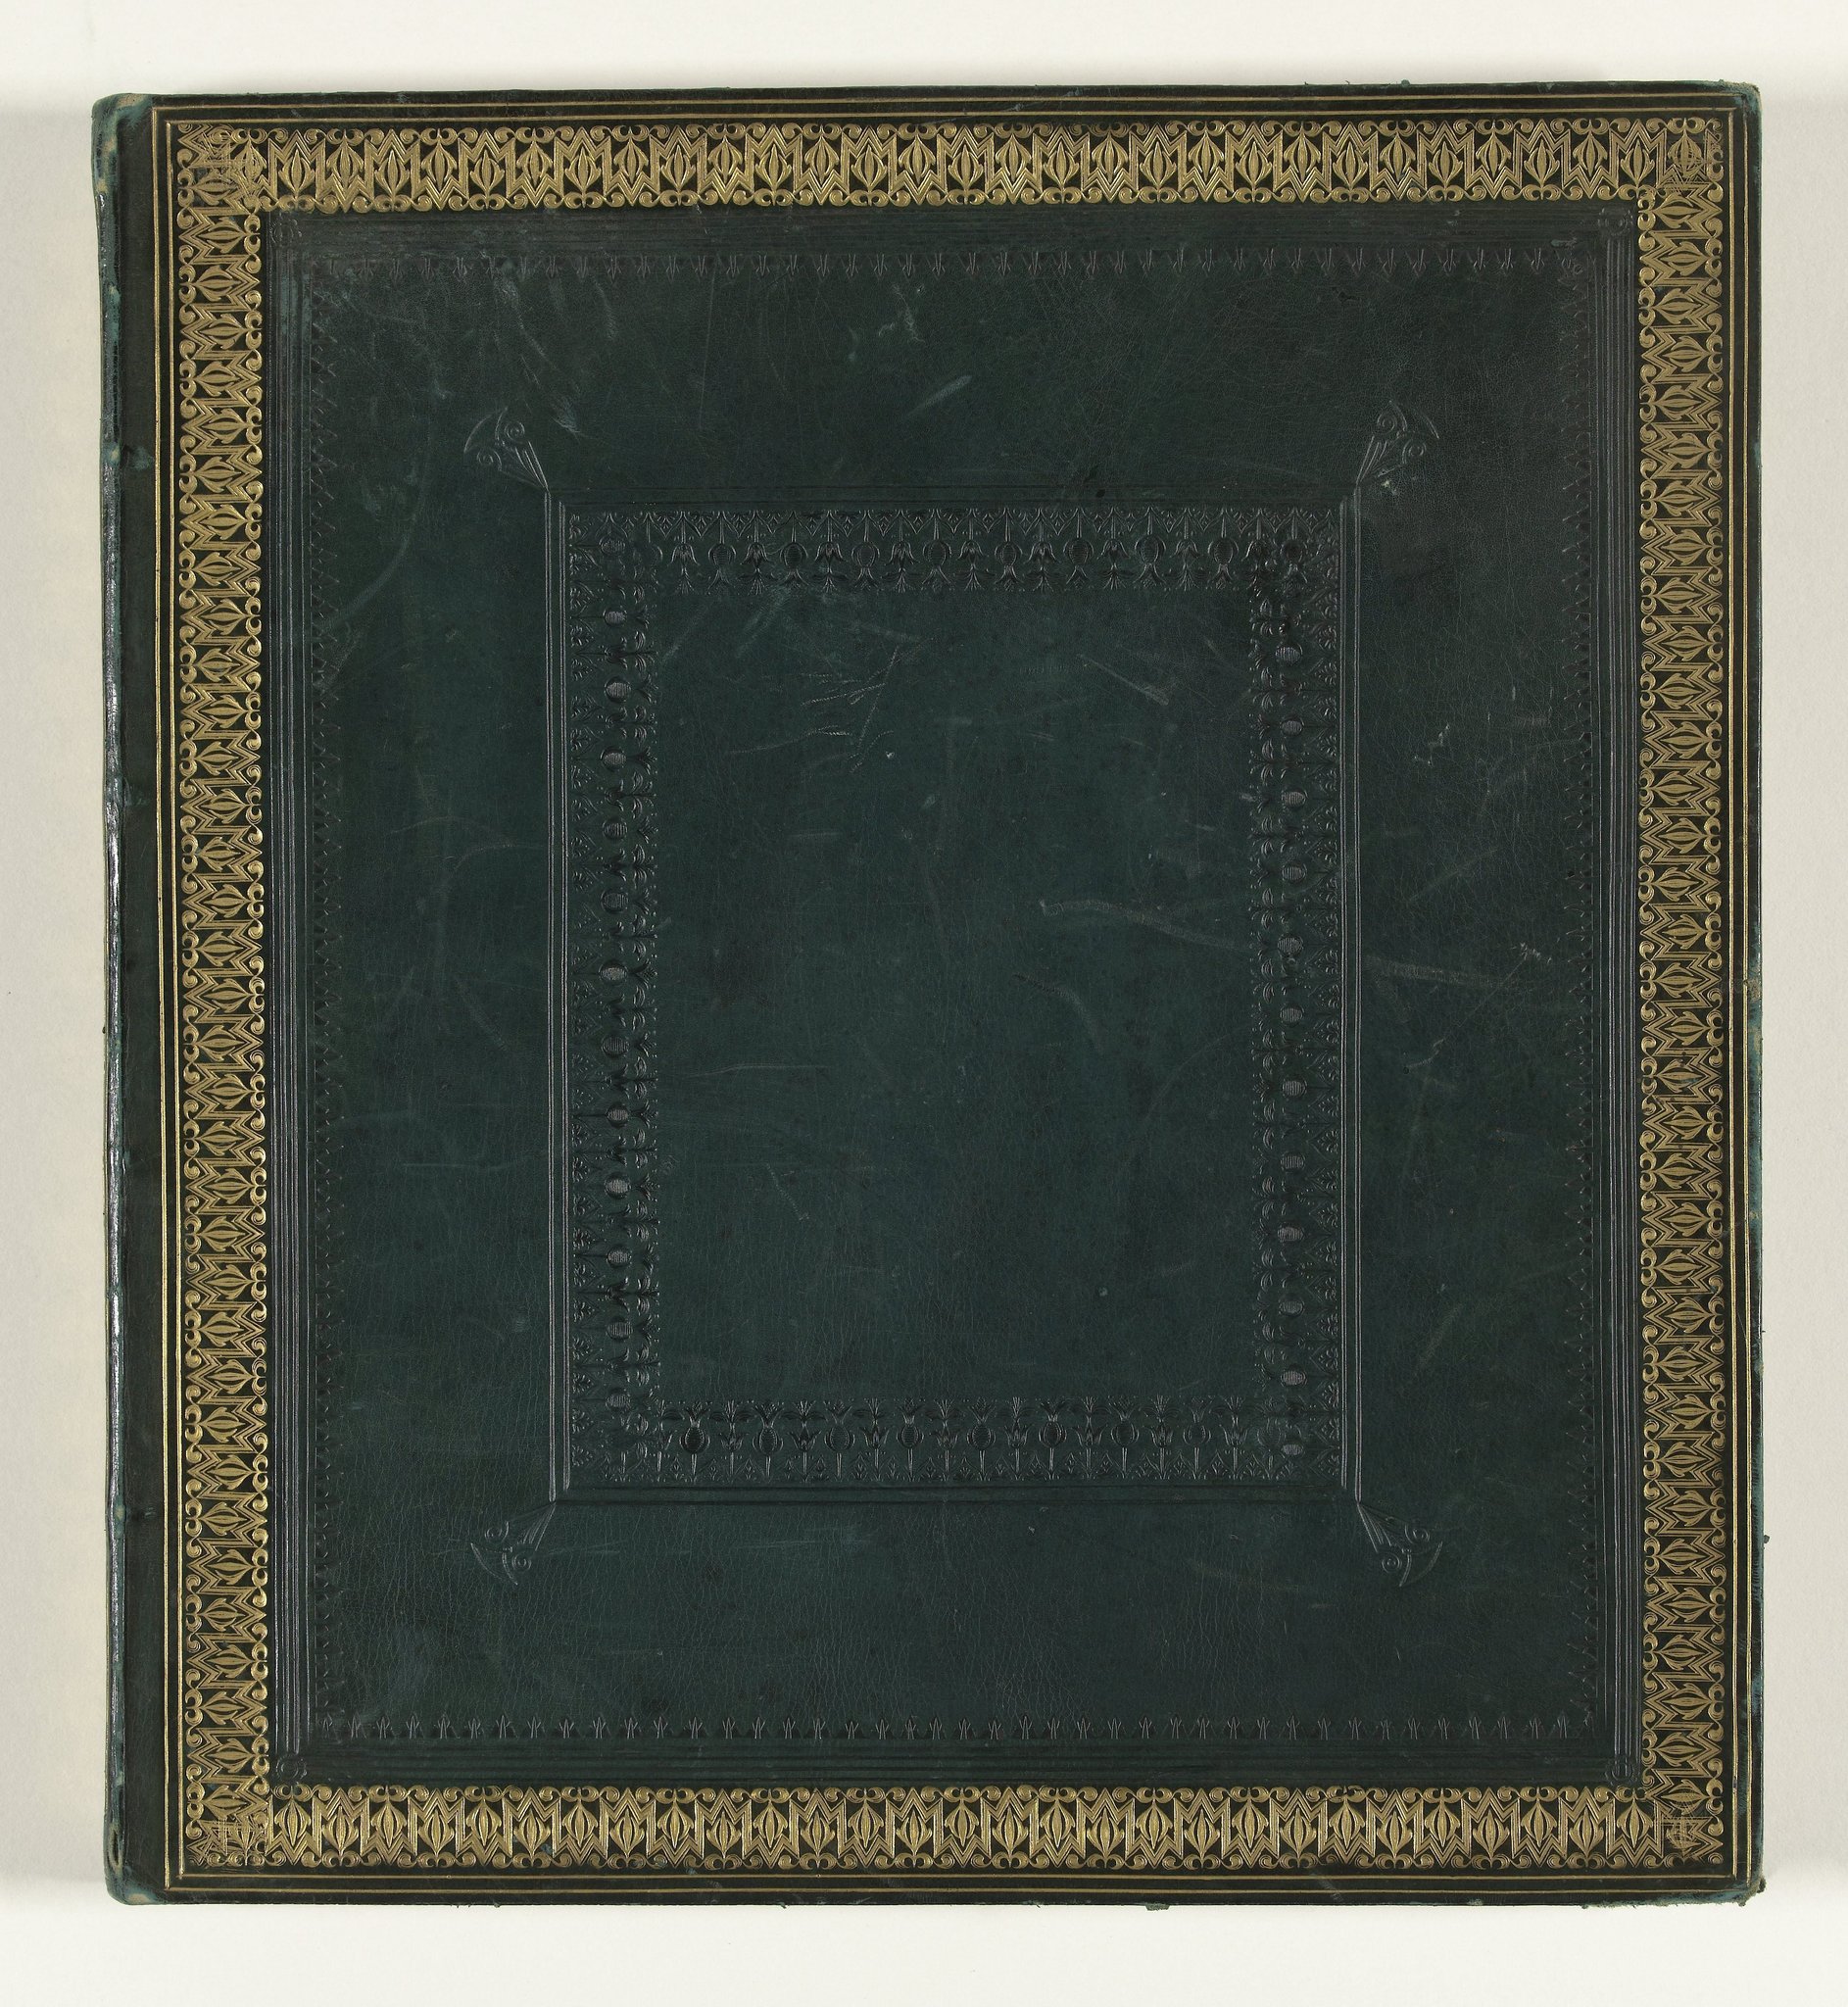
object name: book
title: Boek van de landbouw en de zijdecultuur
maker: Anonymous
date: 1810-1870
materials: paper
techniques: woodcut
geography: china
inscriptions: inscription: ‘Kang Chi T'U’